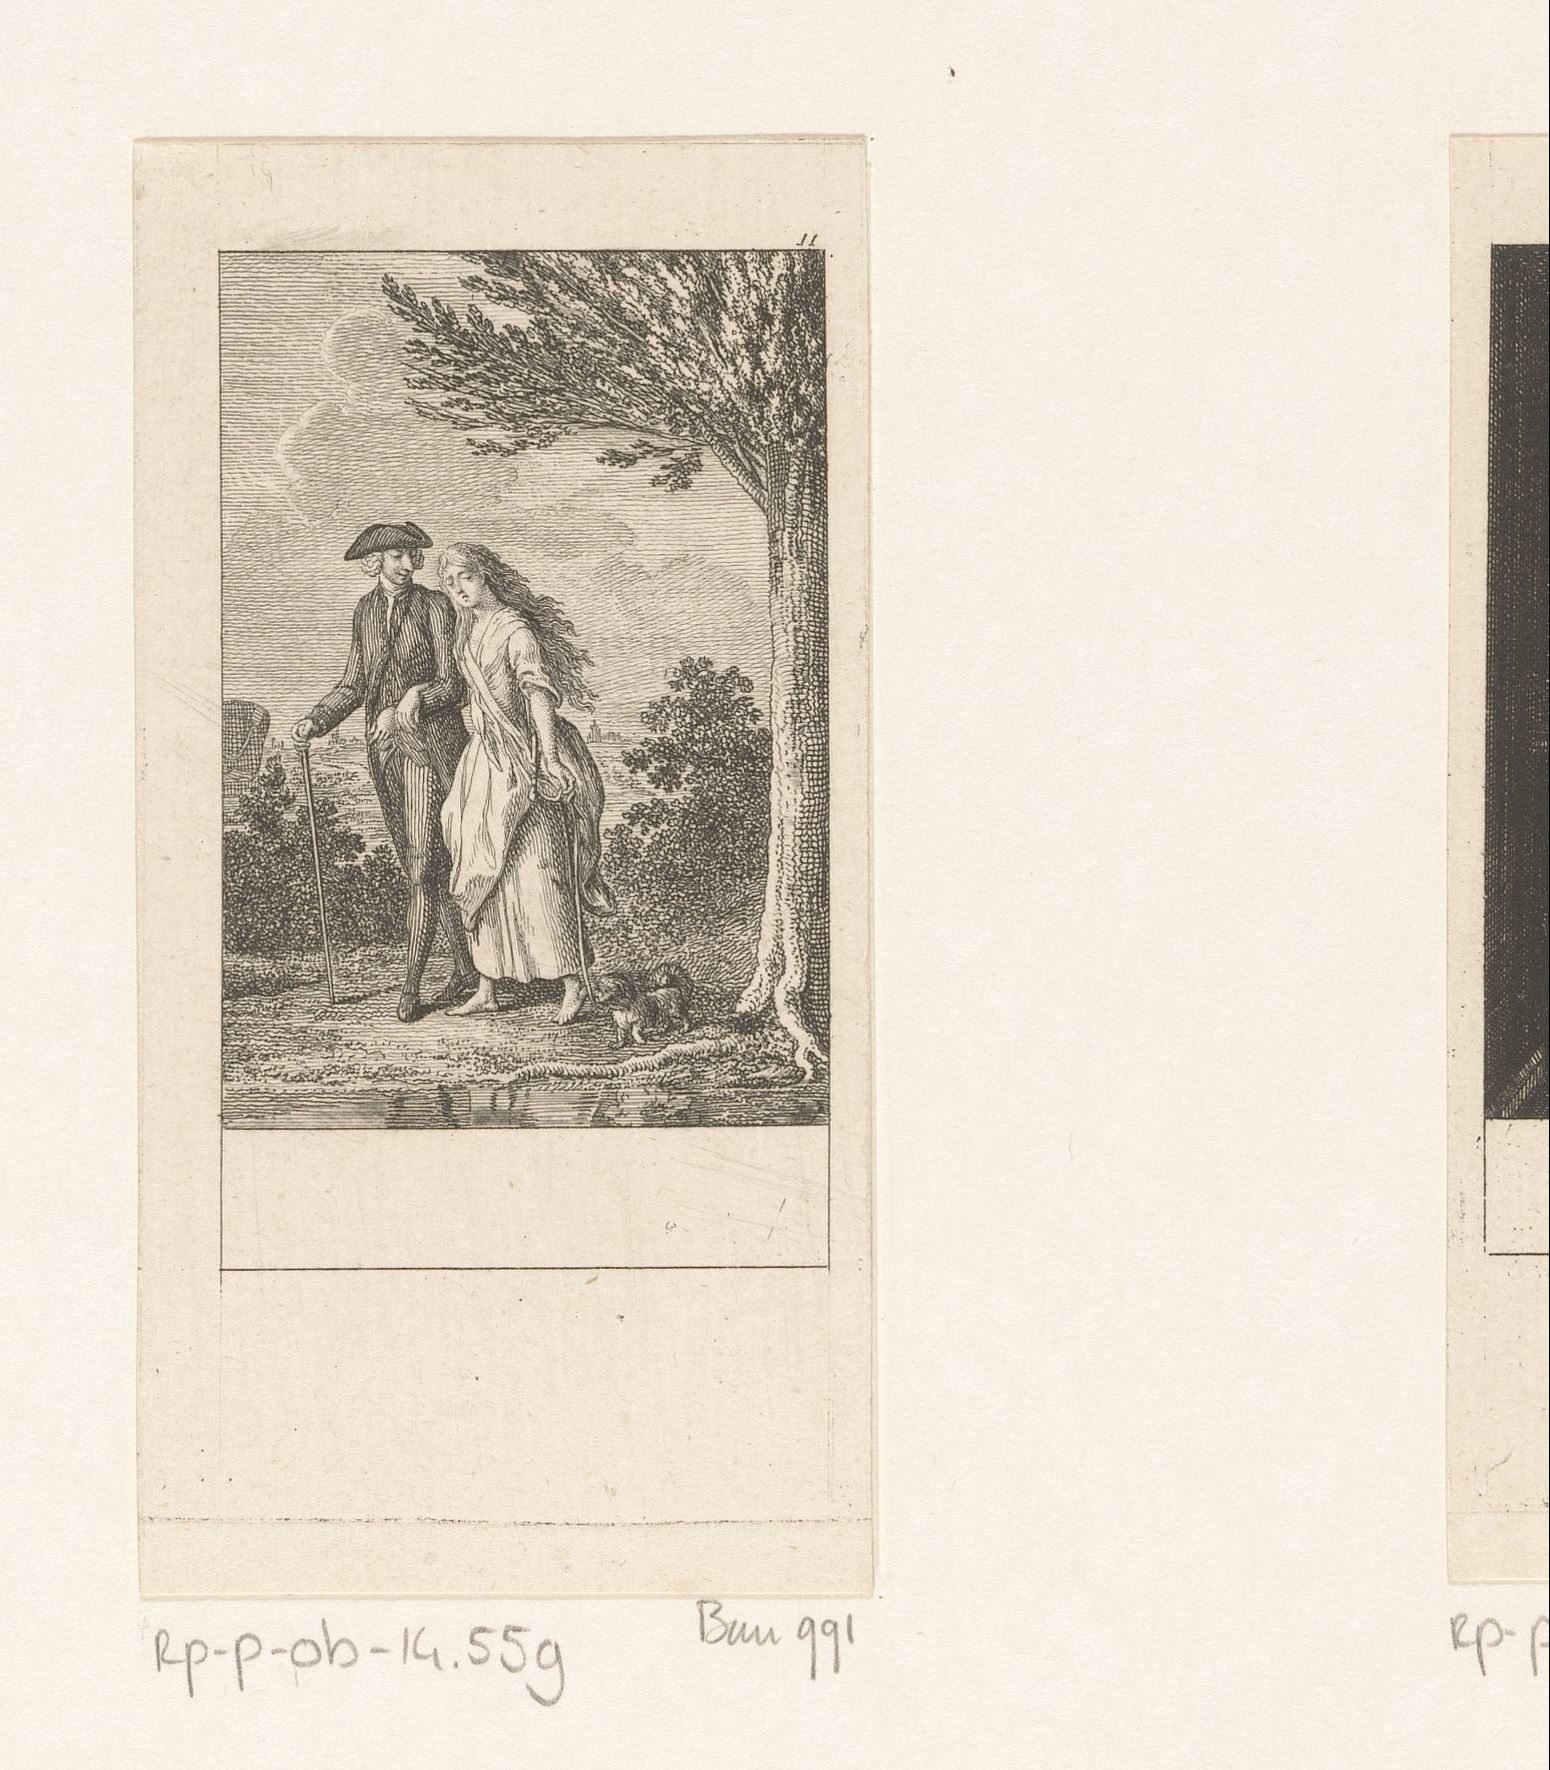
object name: print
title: Yorick en Maria wandelen arm in arm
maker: daniel nikolaus chodowiecki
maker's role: draughtsman, print maker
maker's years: 1726-1801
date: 1783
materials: paper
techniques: etching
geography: berlin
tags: london, clergyman, literature, garden, walking the dog, walking arm in arm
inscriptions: collector's mark: Lugt 2228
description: Vervaardigd voor Laurence Sternes 'empfindsame Reise'. Prent gebruikt voor: Berliner genealogischen Calender auf das Schalt Jahr 1784. S.l.s.n., [1783].